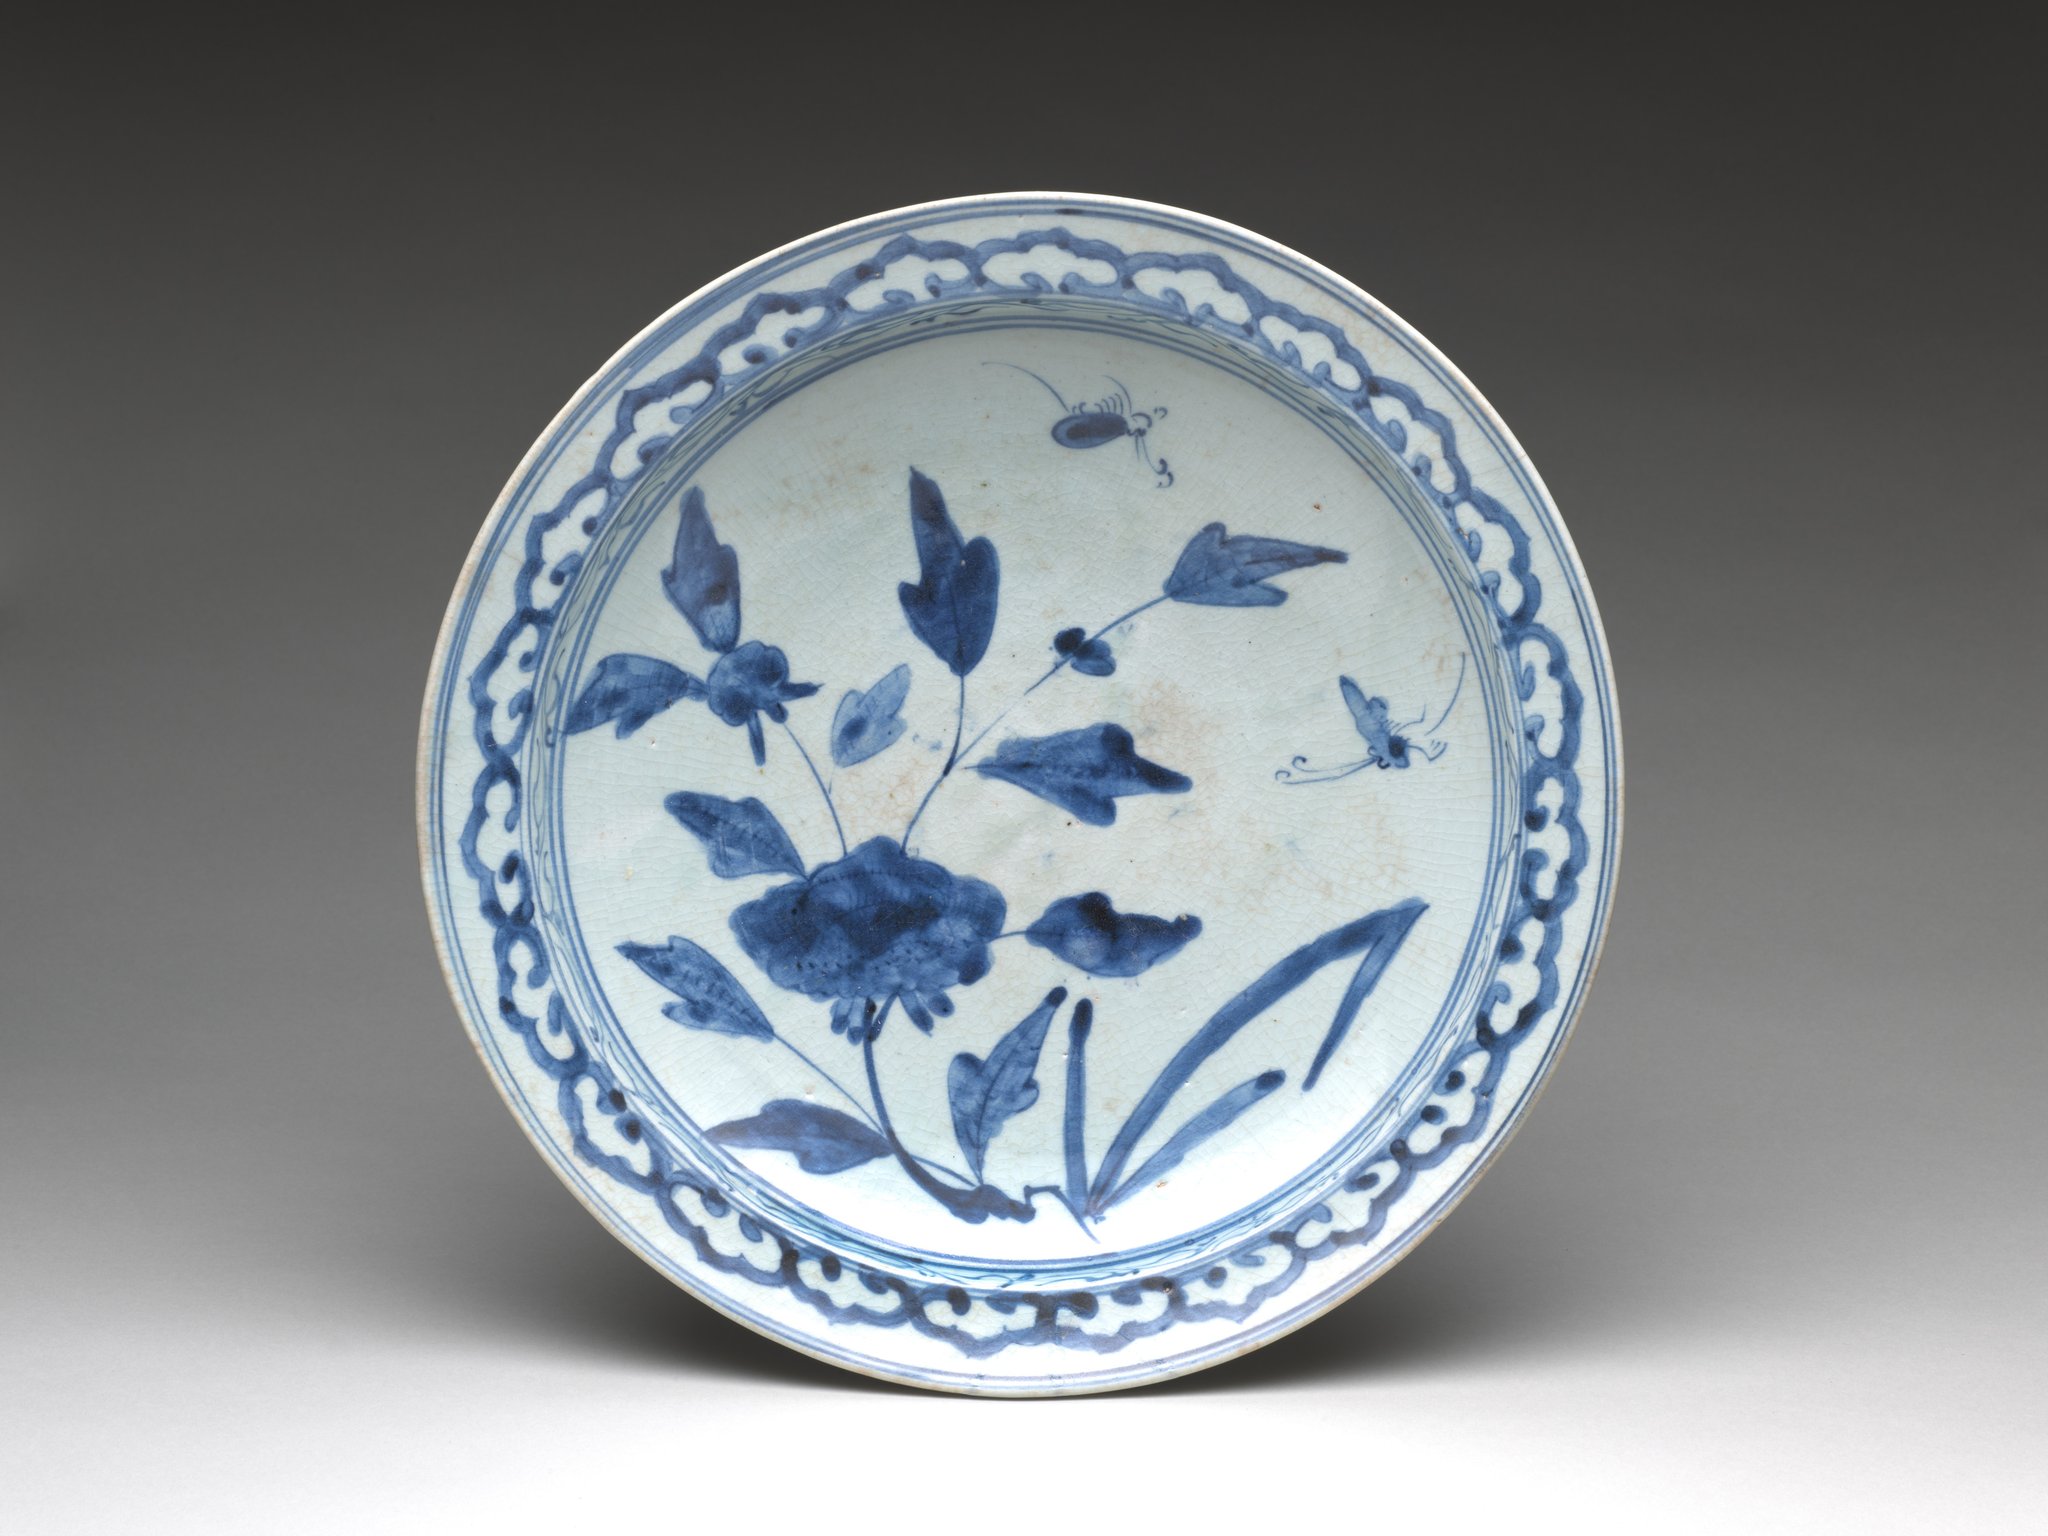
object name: plate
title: Large Plate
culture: japanese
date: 1624-1643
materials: stoneware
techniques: painting, underglaze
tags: flowers